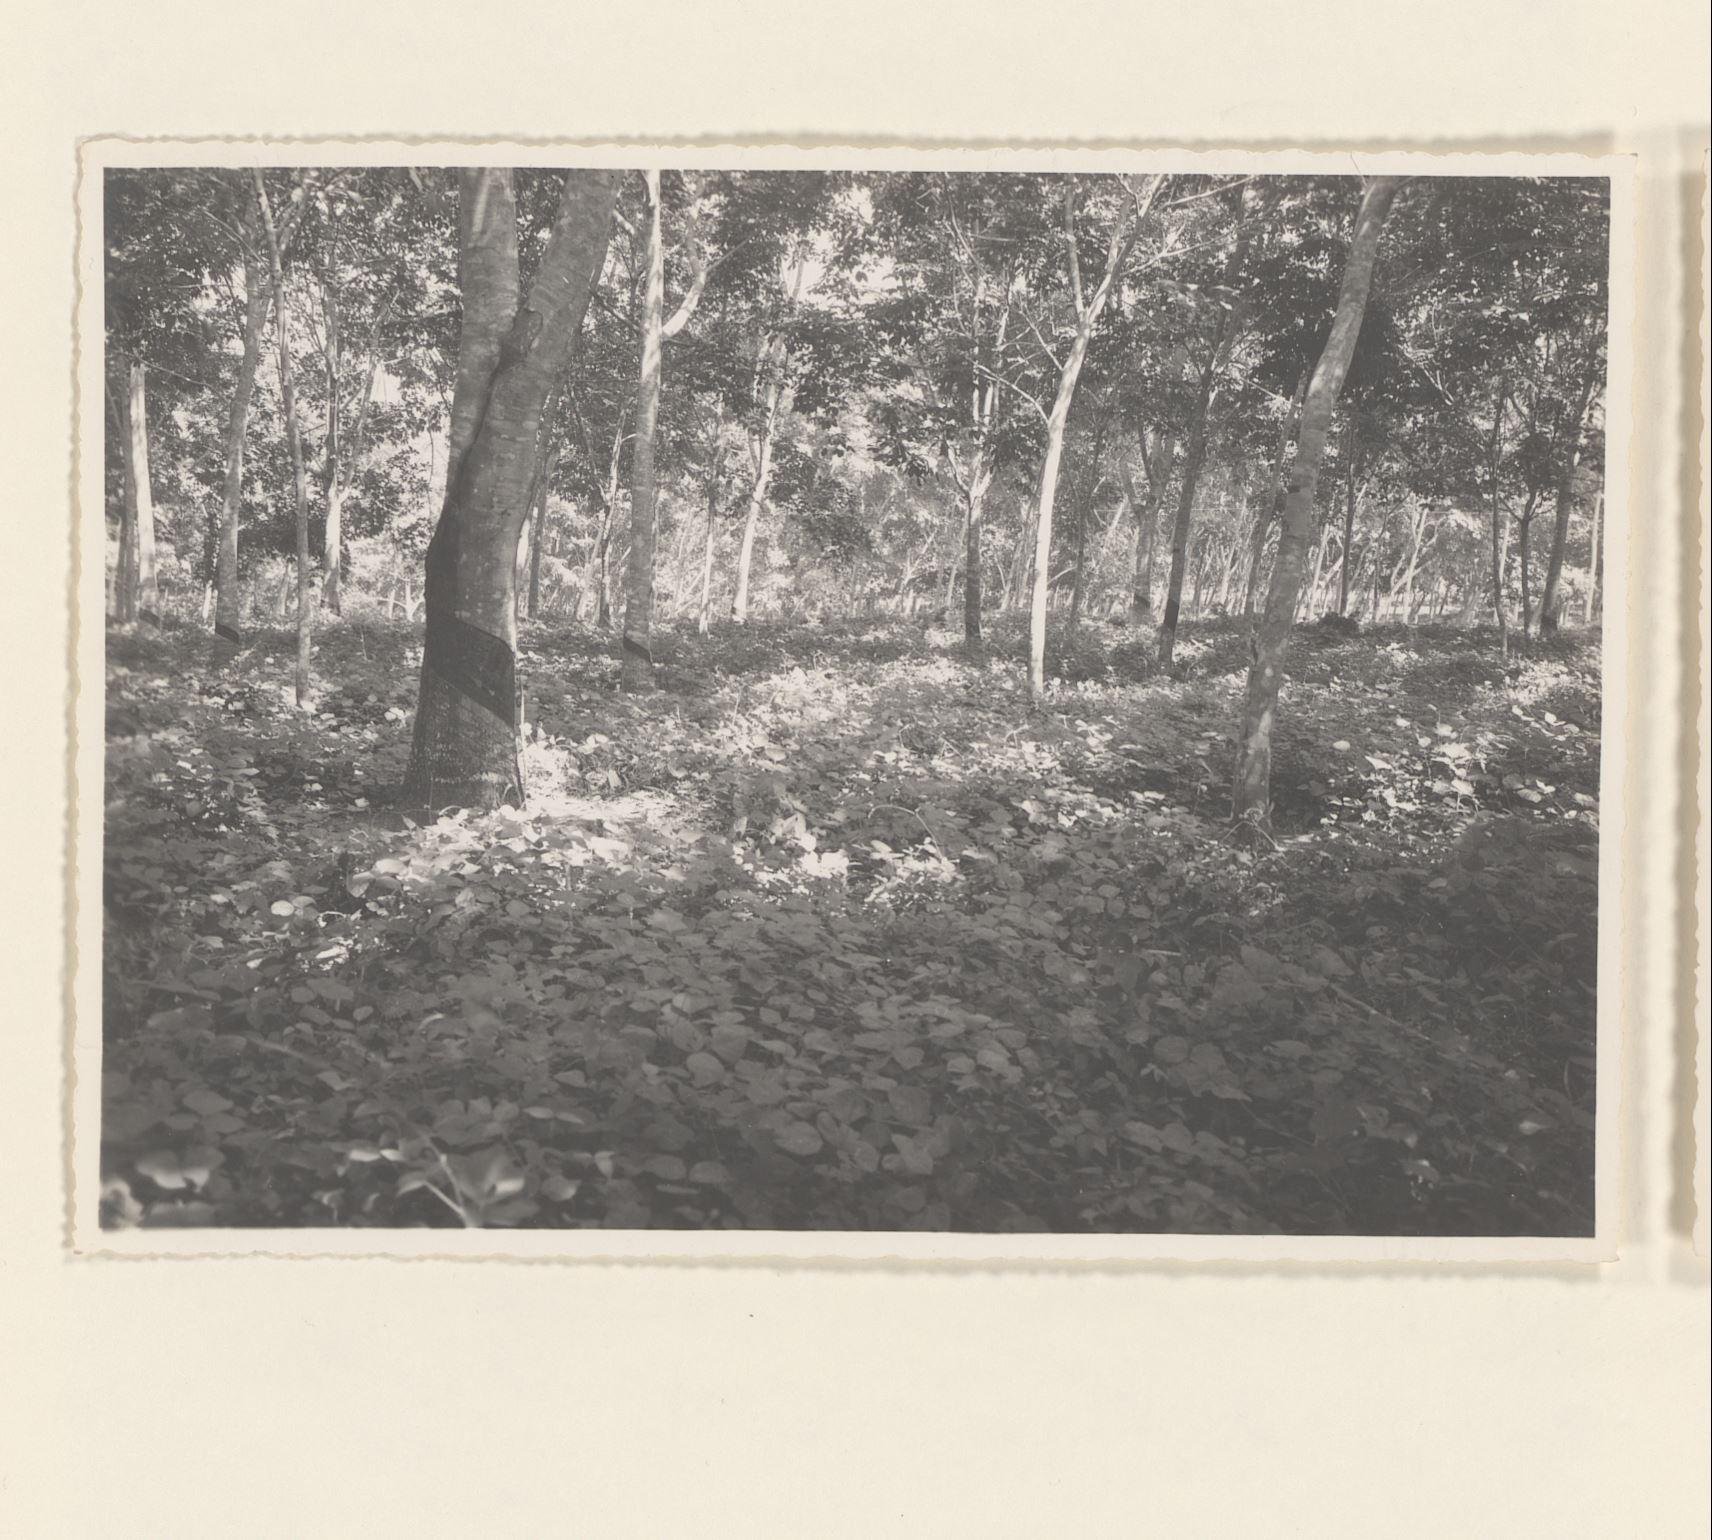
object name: photograph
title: Zaailing naast oculatie Brussel afd. III Augs '38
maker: Anonymous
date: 1908-1938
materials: photographic support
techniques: gelatin silver print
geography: sumatra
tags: plantation, (non-fruit) products of plants or trees: rubber, sumatra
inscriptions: inscription: ‘Zaailing naast oculatie Brussel afd. III Augs '38’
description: Rubberbomen op de plantage Brussel, augustus 1938. Tweede afdruk, los in melinexhoesje, van een foto ingeplakt op albumblad 8. Onderdeel van het fotoalbum over de plantages Pernantian en Brussel van de Sumatra Caoutchouc Maatschappij op de Oostkust van Sumatra in de jaren 1935-1939.